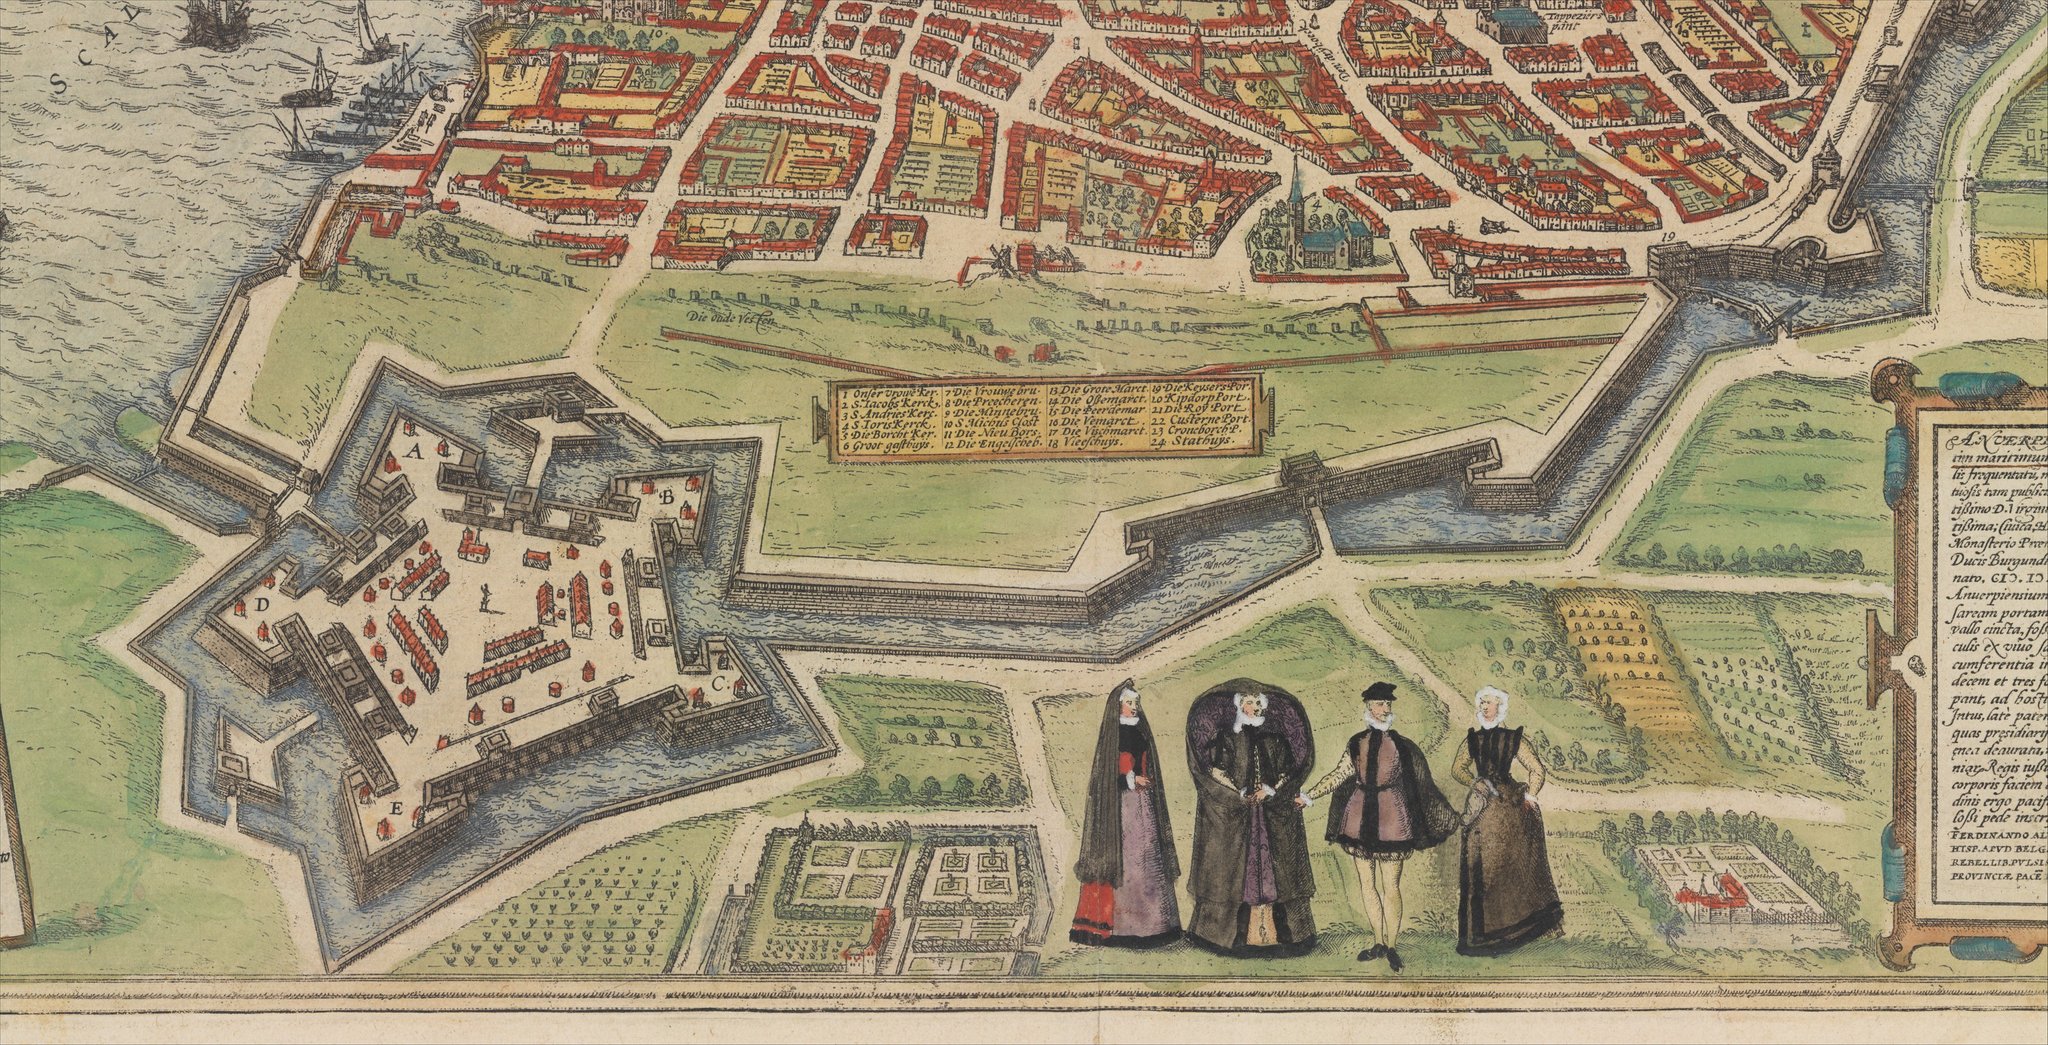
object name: print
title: Palazzo Farnese at Caprarola from Braun and Hogenberg's Civitates Orbis Terrarum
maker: frans hogenberg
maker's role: artist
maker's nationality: netherlandish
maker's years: 1540-1590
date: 1572-1594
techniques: etching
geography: germany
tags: men,women,maps